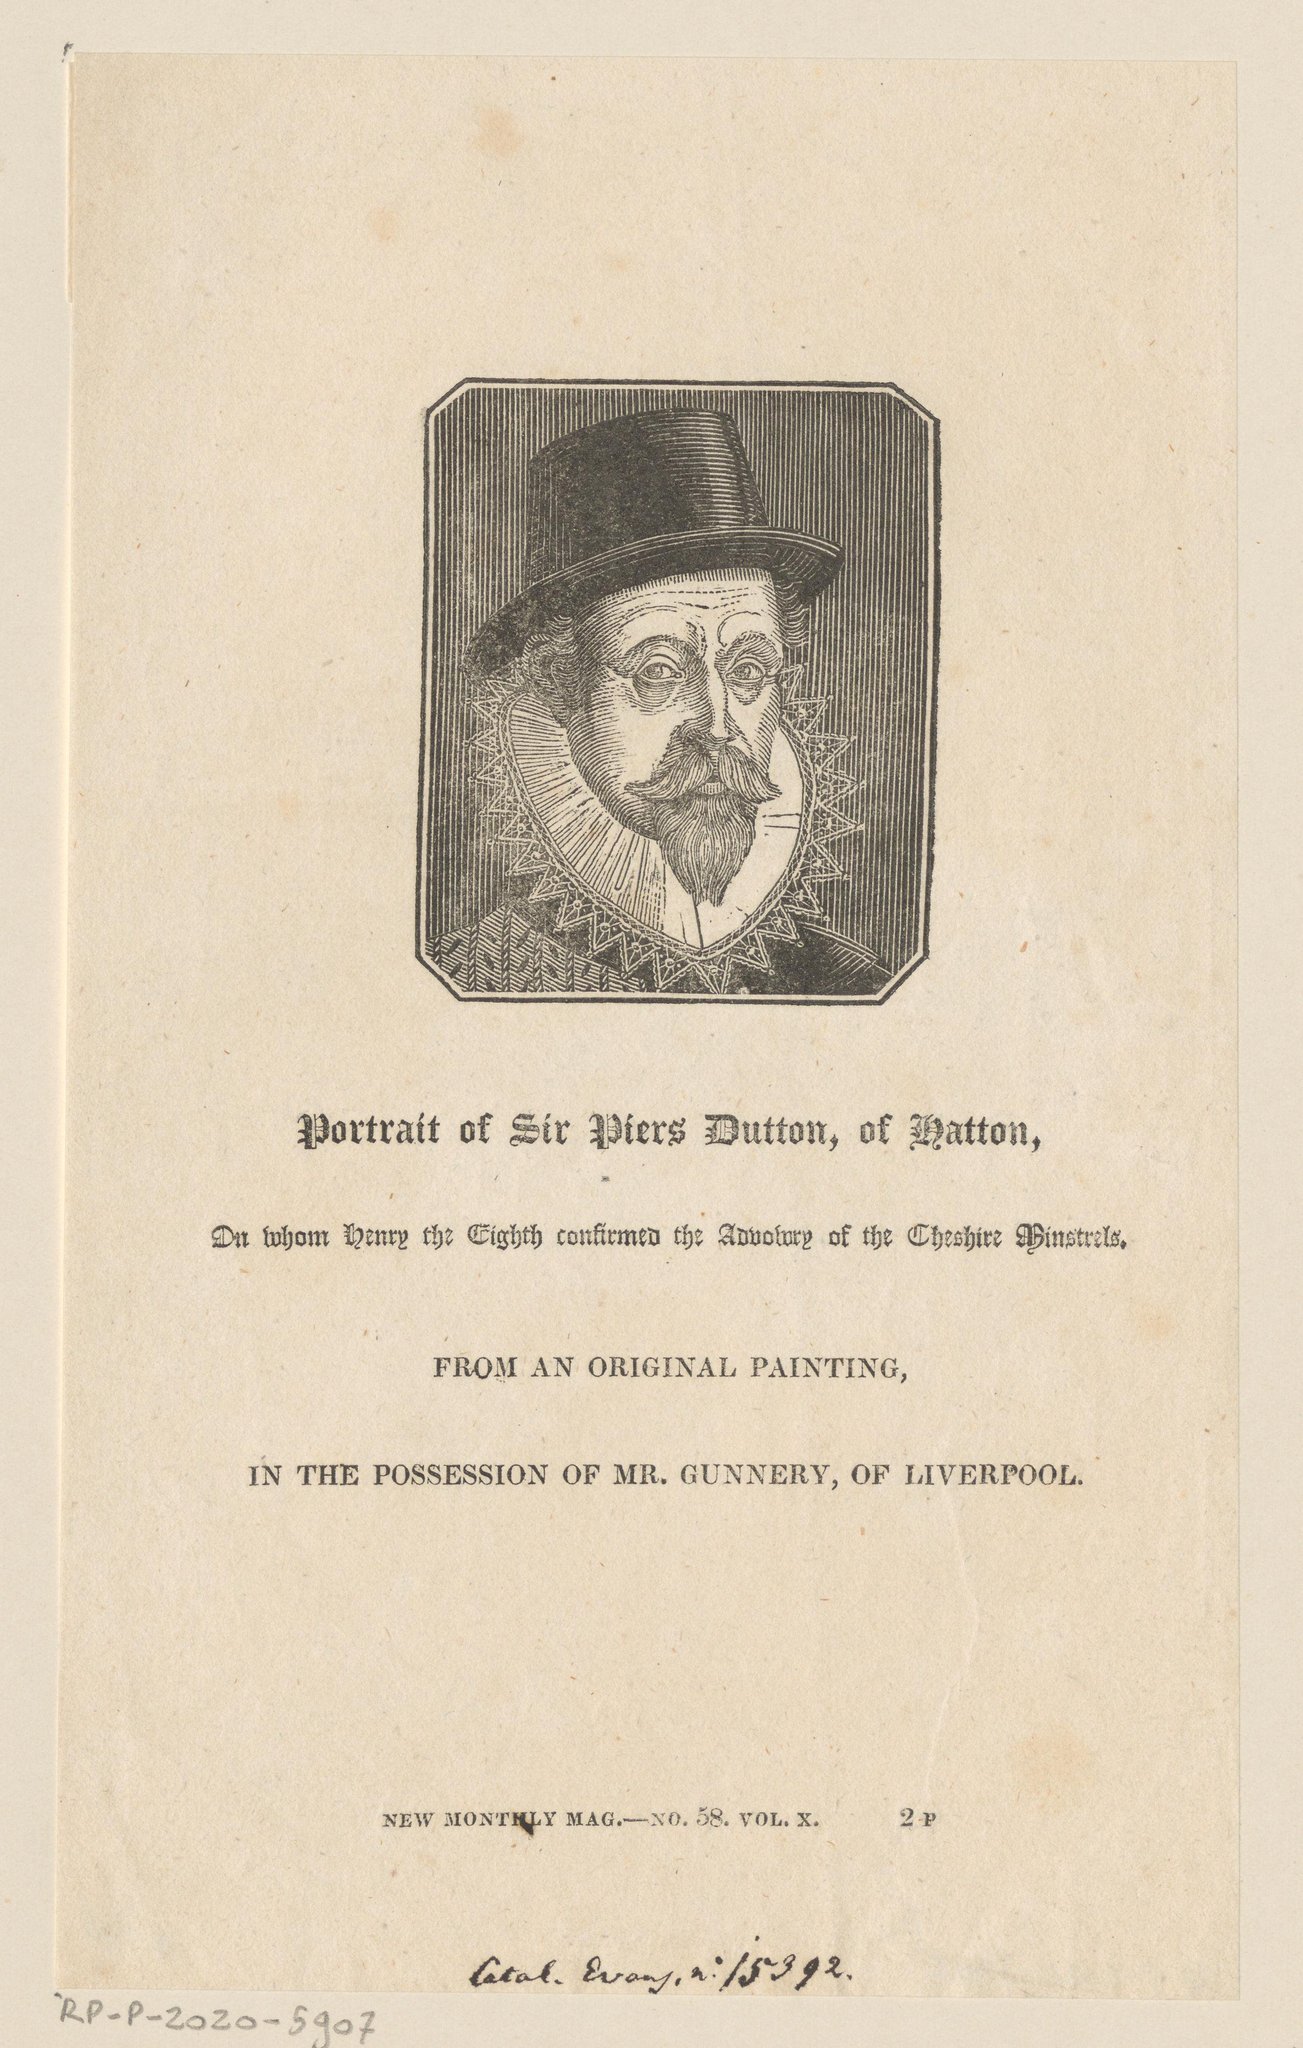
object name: print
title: Portret van Piers Dutton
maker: Anonymous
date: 1818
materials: paper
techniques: letterpress printing, engraving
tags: mayor, burgomaster, historical persons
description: Prent uit: The New Monthly Magazine 10 (1818), nr. 58, 1 november 1818.